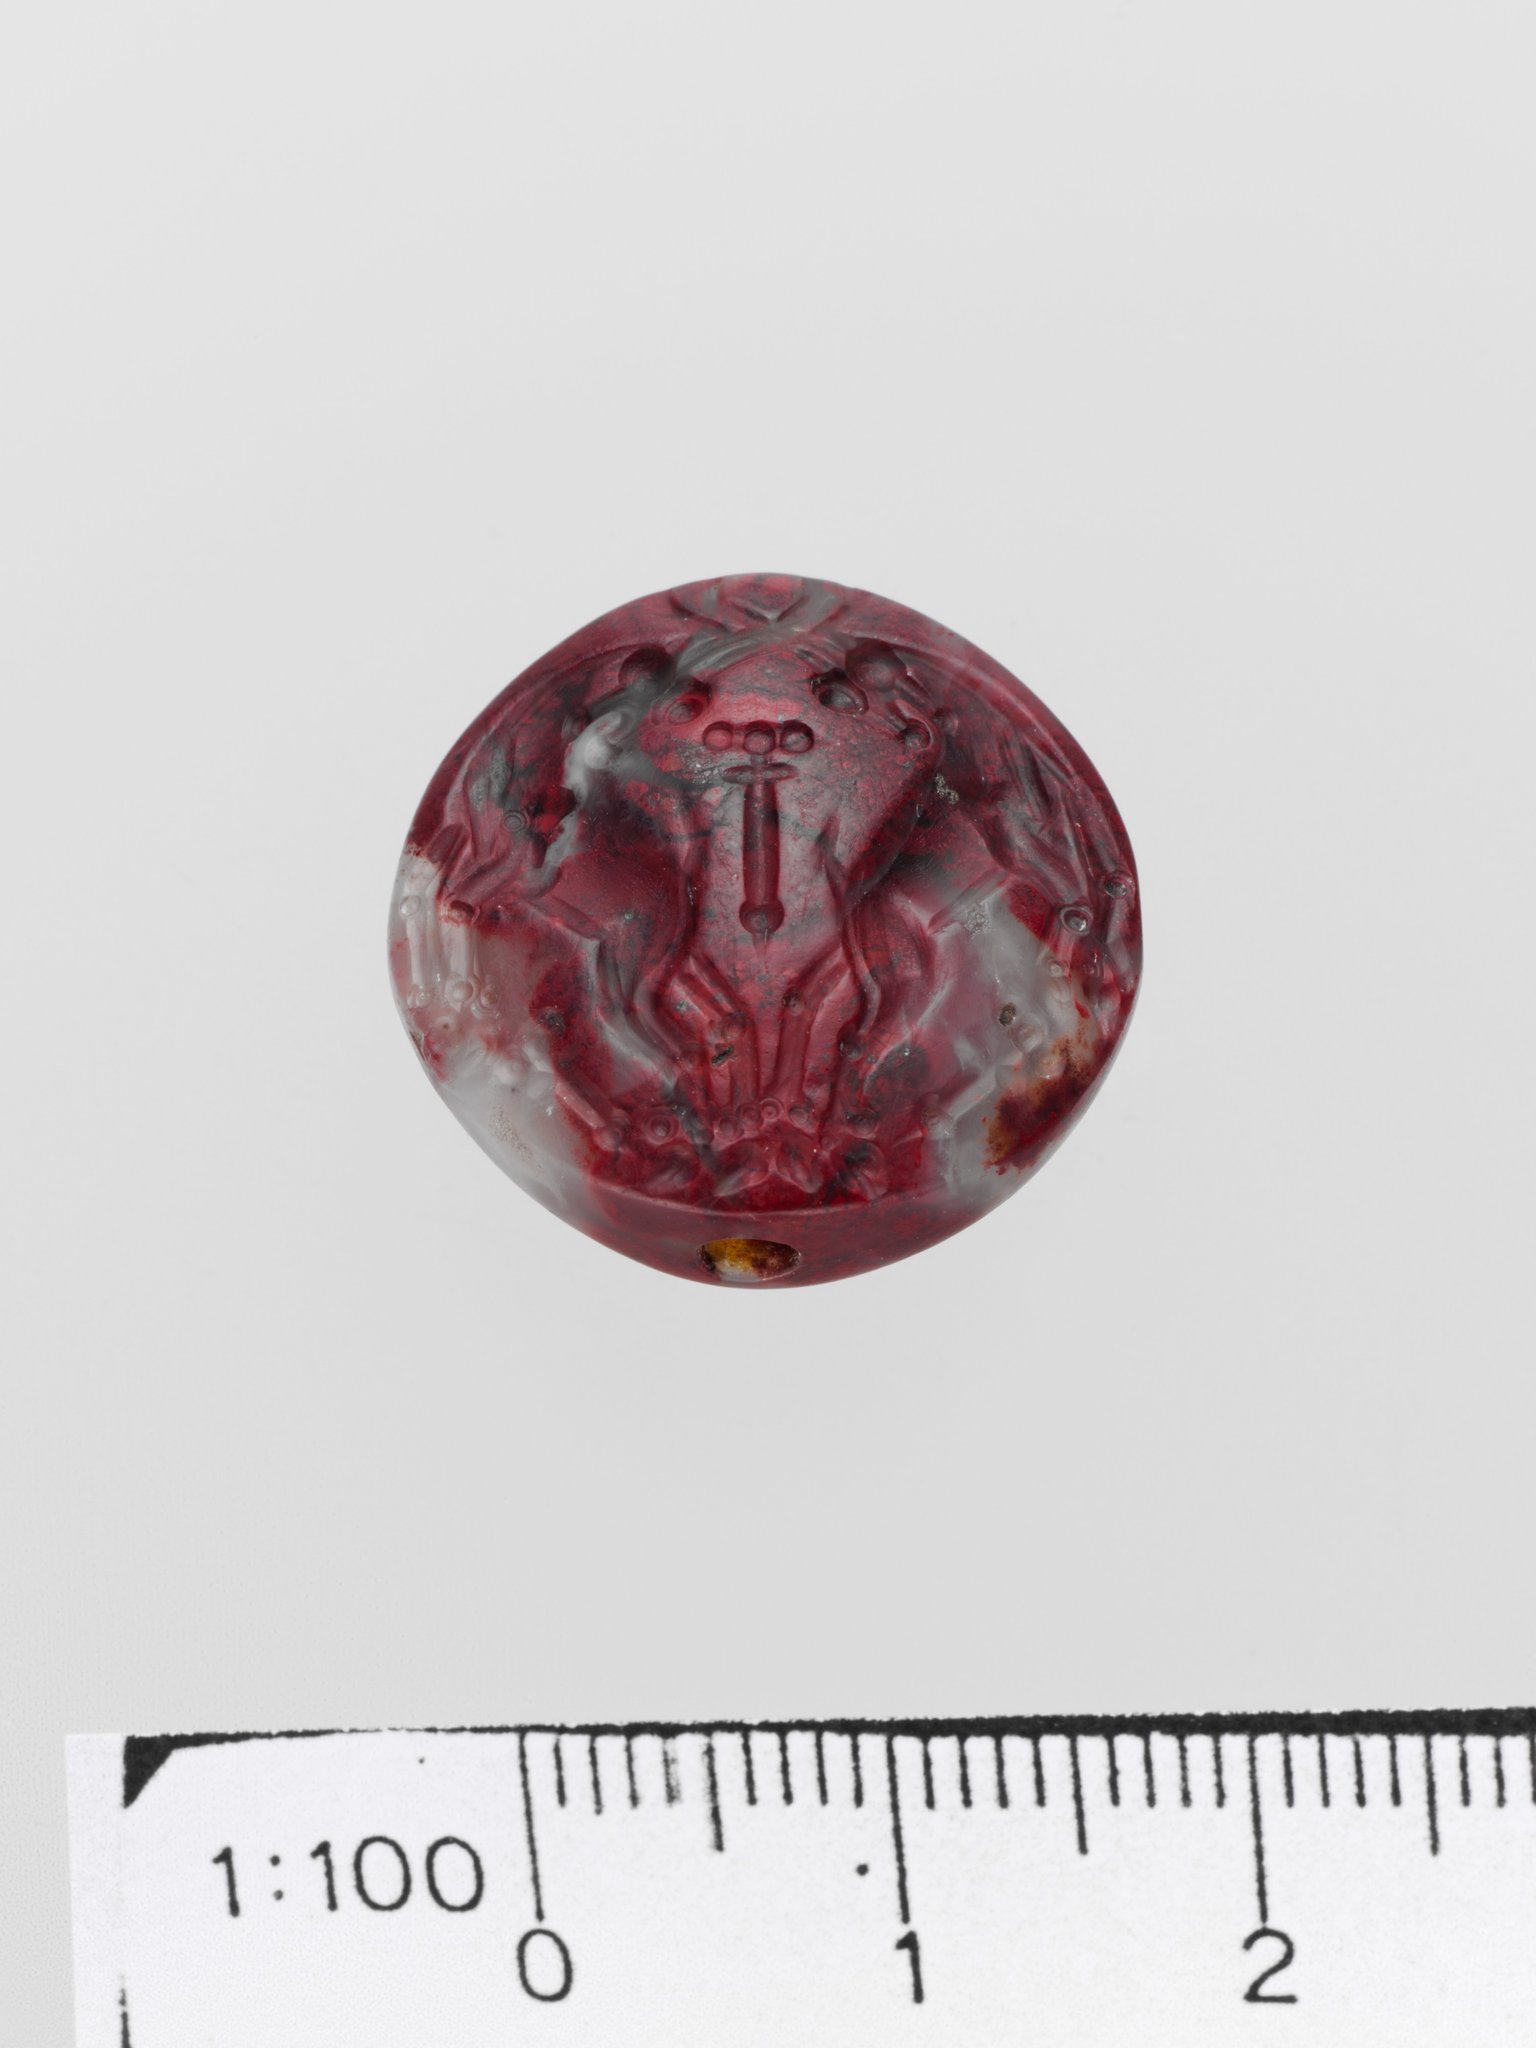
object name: seal, lentoid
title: Agate lentoid seal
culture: minoan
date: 1400-1300 BCE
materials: stone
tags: goats